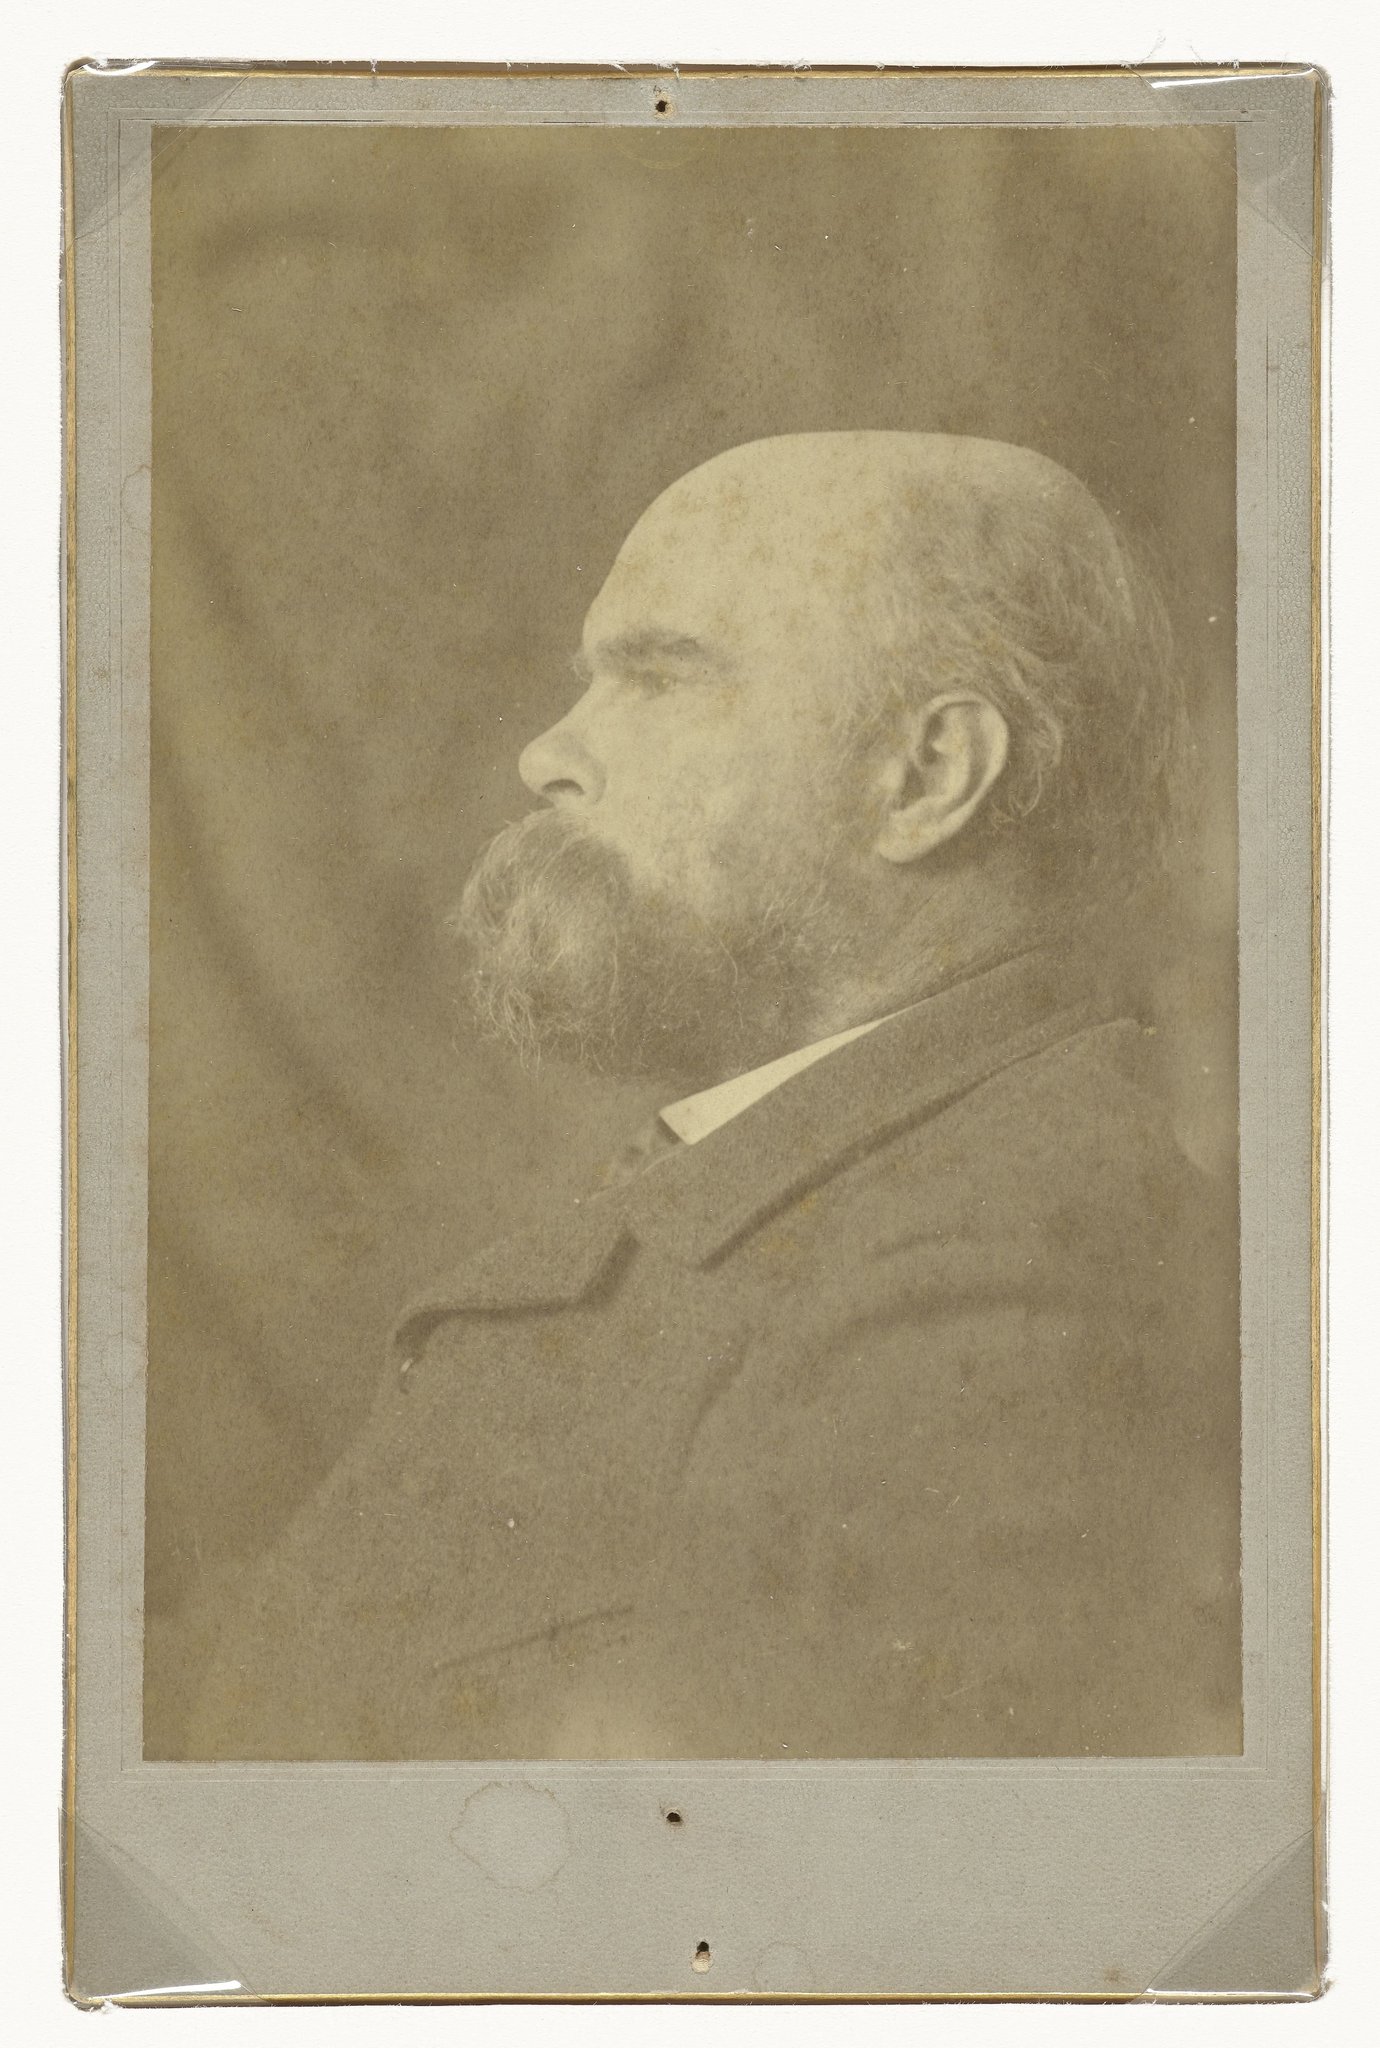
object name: photograph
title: Portret van Paul Verlaine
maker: philip zilcken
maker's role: draughtsman, painter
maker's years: 1857-1930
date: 1811-1892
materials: cardboard, paper, photographic support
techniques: albumen print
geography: netherlands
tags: paris, paul verlaine, historical persons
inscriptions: signature and date: ‘P. Verlaine ("Hélène Villa") 1892-XI PhZ phot:’